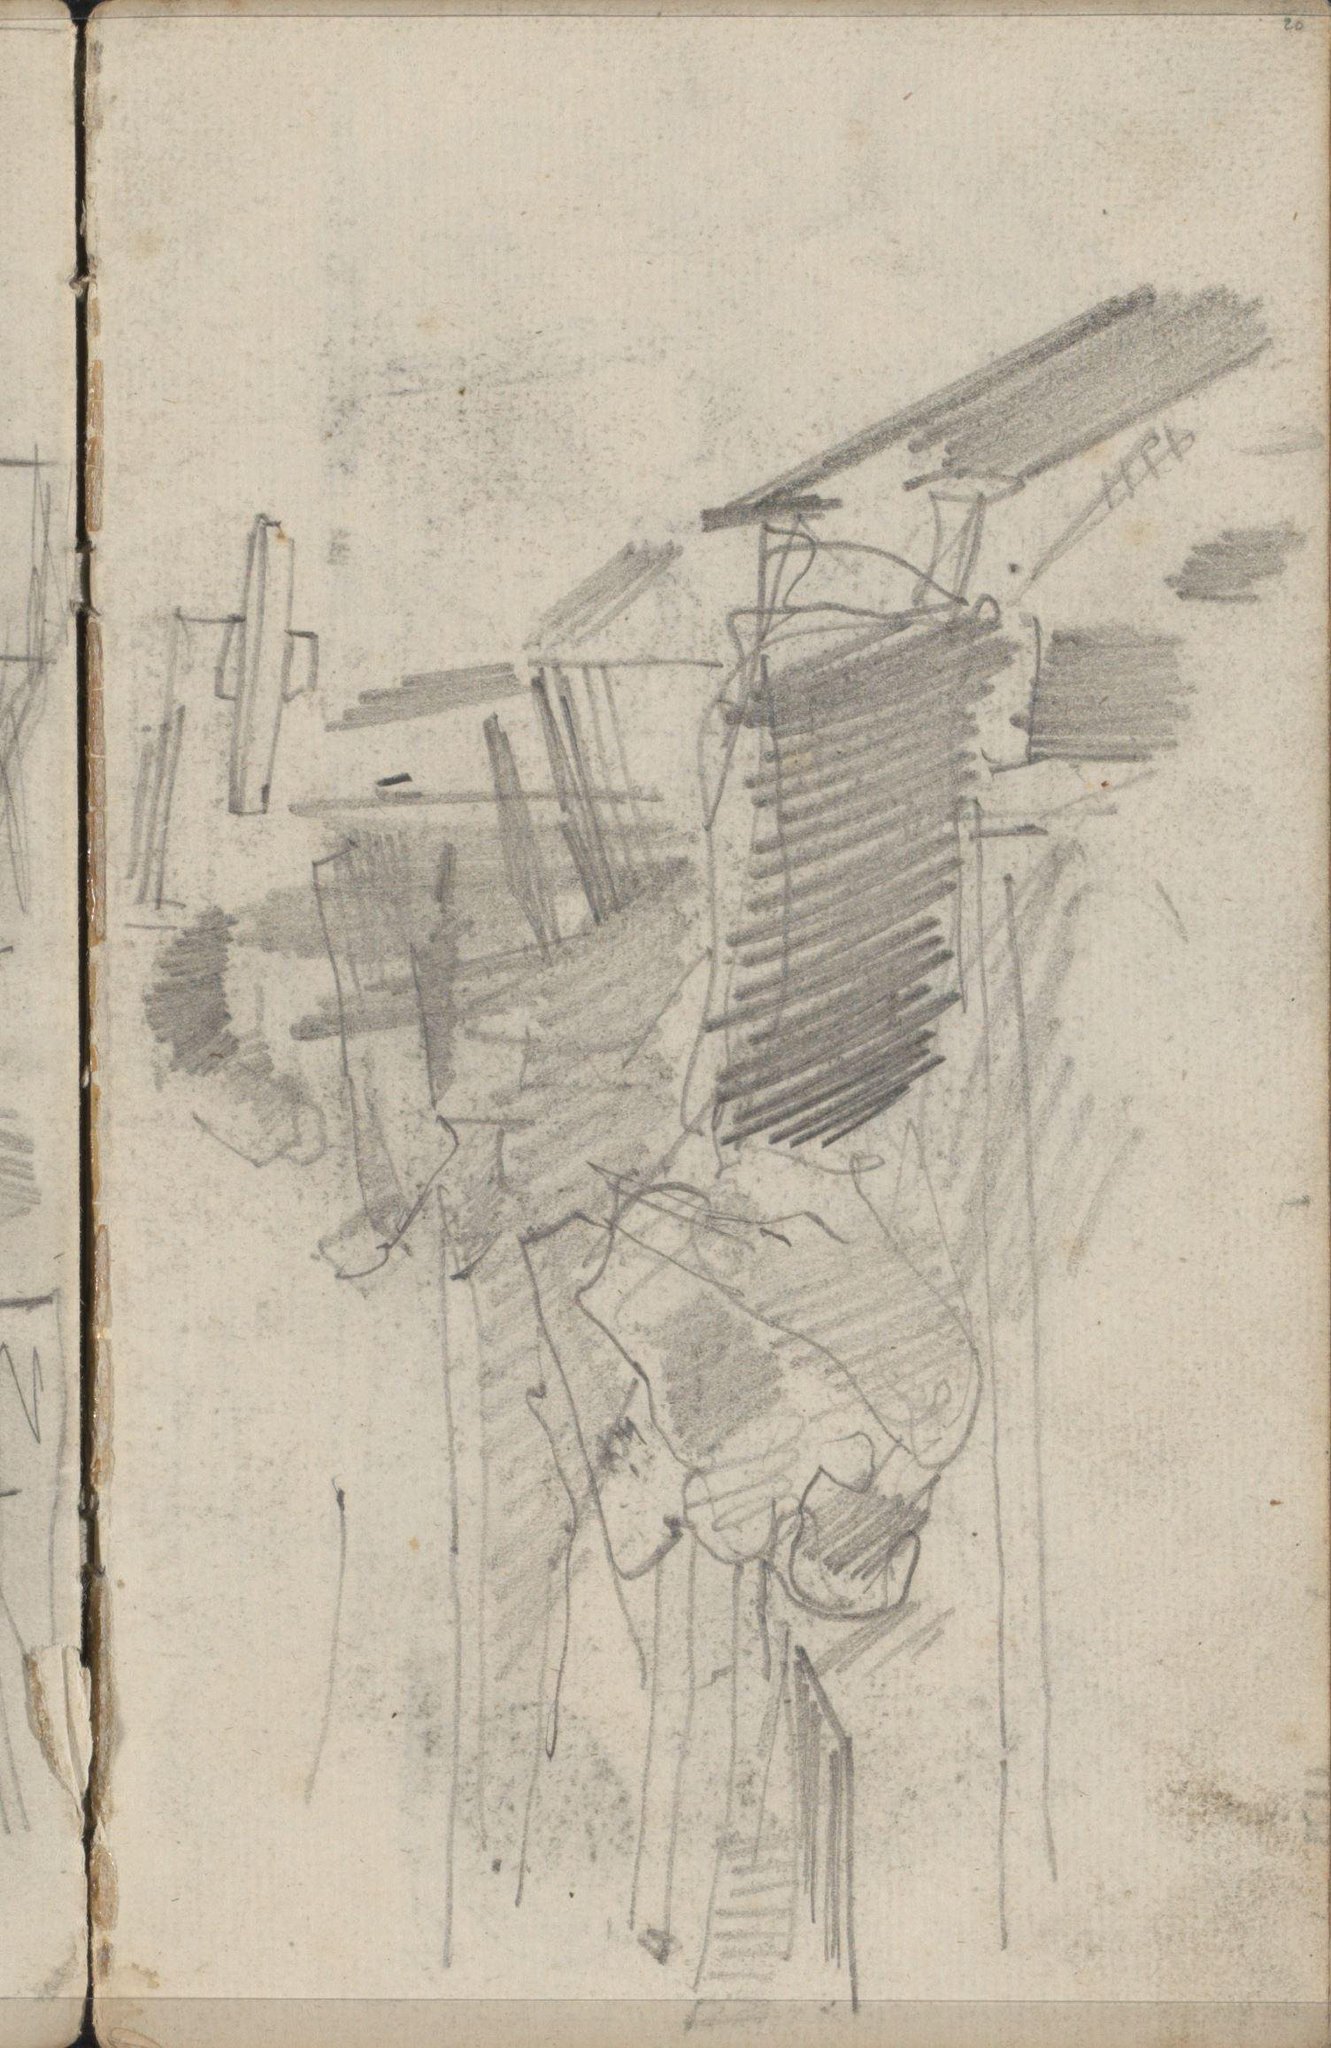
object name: sketchbook leaf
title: Figuren, mogelijk in een interieur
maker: george hendrik breitner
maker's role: draughtsman, painter, print maker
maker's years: 1857-1923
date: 1881-1883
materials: paper, pencil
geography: rotterdam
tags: adult woman, interior of the house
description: Pagina 20 uit een schetsboek met 27 bladen